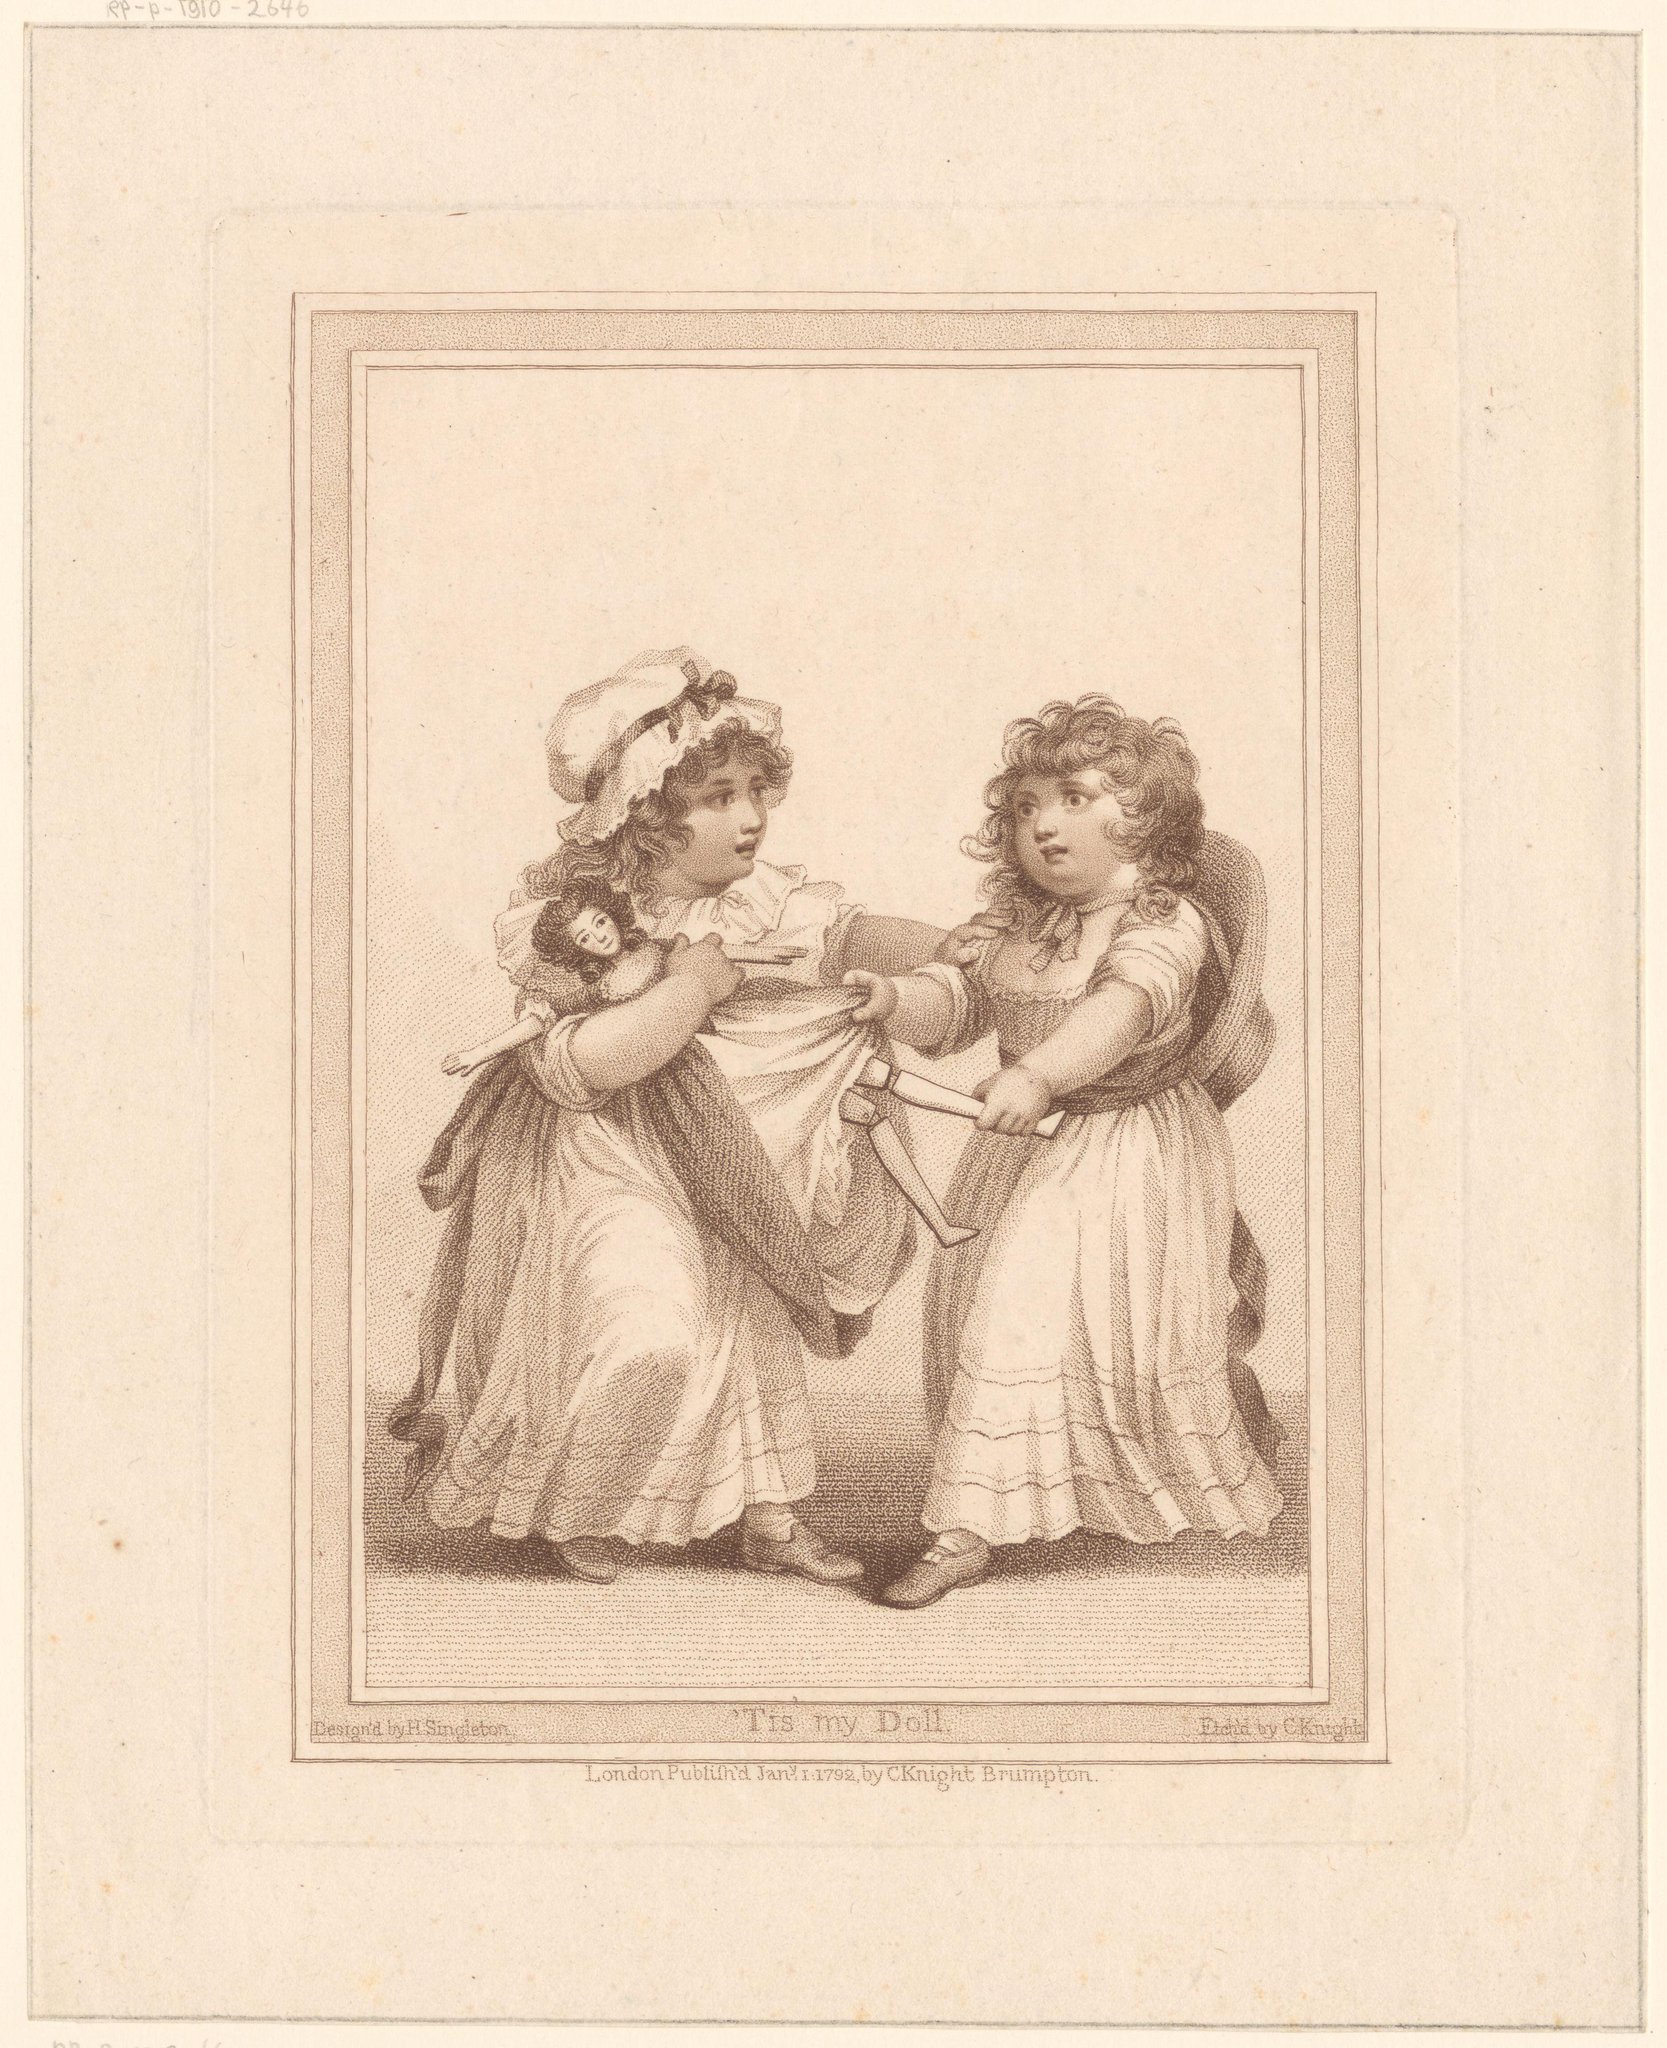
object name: print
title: 'Tis my Doll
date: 1792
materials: paper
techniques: etching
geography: london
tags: playing toddler; child amusing itself - aa - girl, (playing with) dolls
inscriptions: collector's mark: Lugt 2233